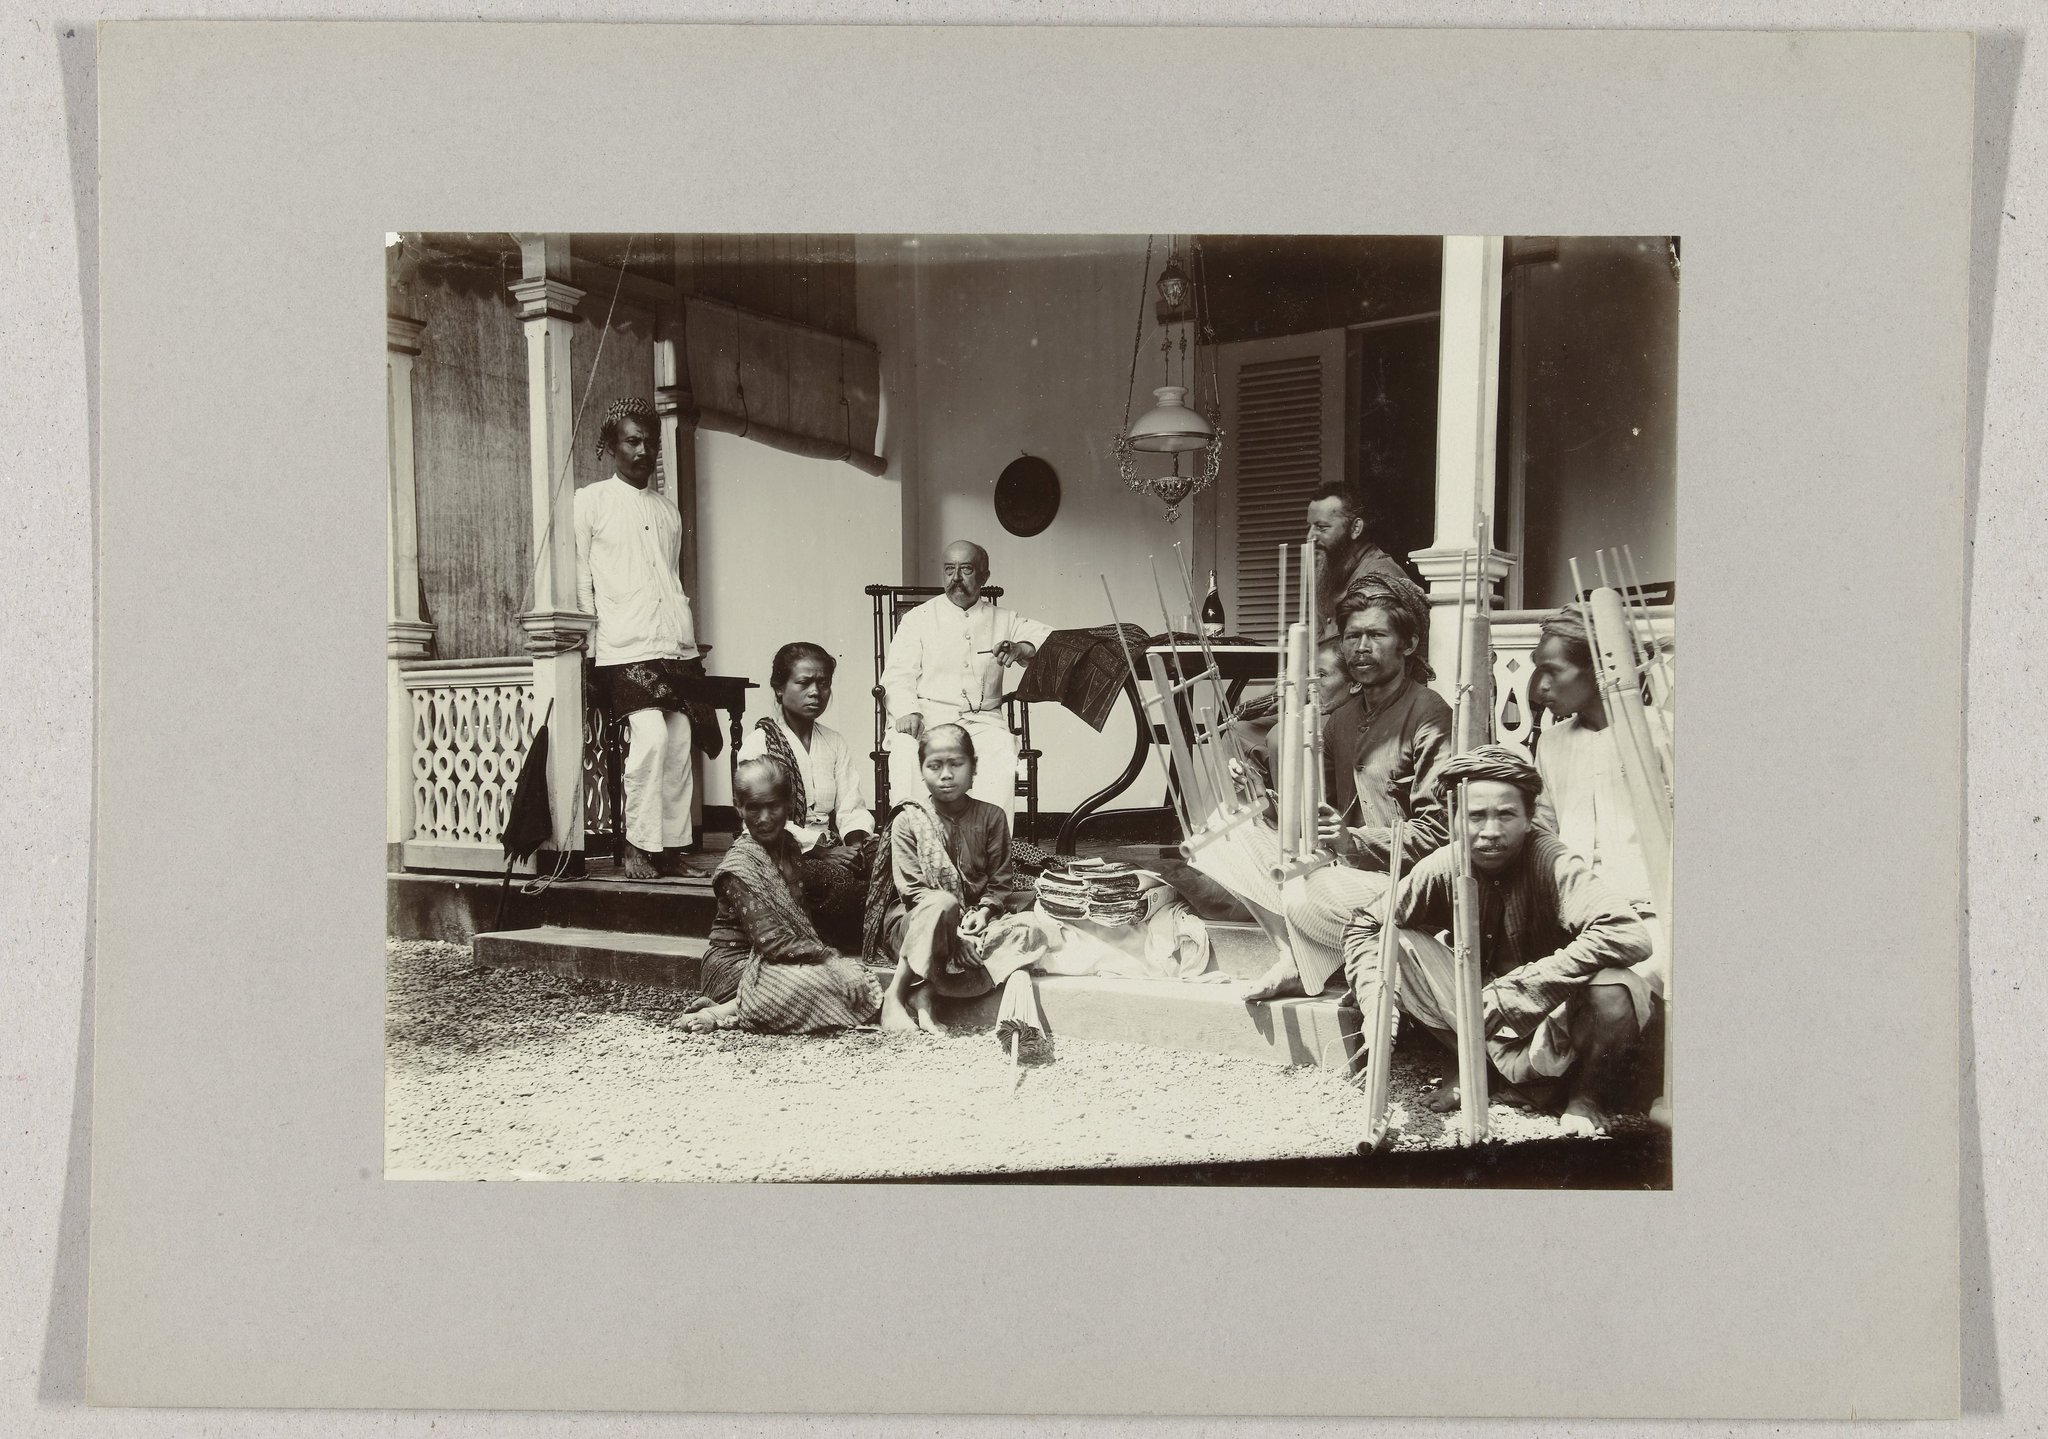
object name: photograph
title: Twee Europese mannen op een veranda, omringd door Indonesische mensen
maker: Anonymous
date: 1895-1915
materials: cardboard, paper, photographic support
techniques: gelatin silver print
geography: dutch east indies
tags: indonesia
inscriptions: number: ‘27’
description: Twee Europese mannen op een veranda, omringd door Indonesische mensen (bedienden en verkopers van stoffen en instrumenten (?) van bamboe), Nederlands-Indië